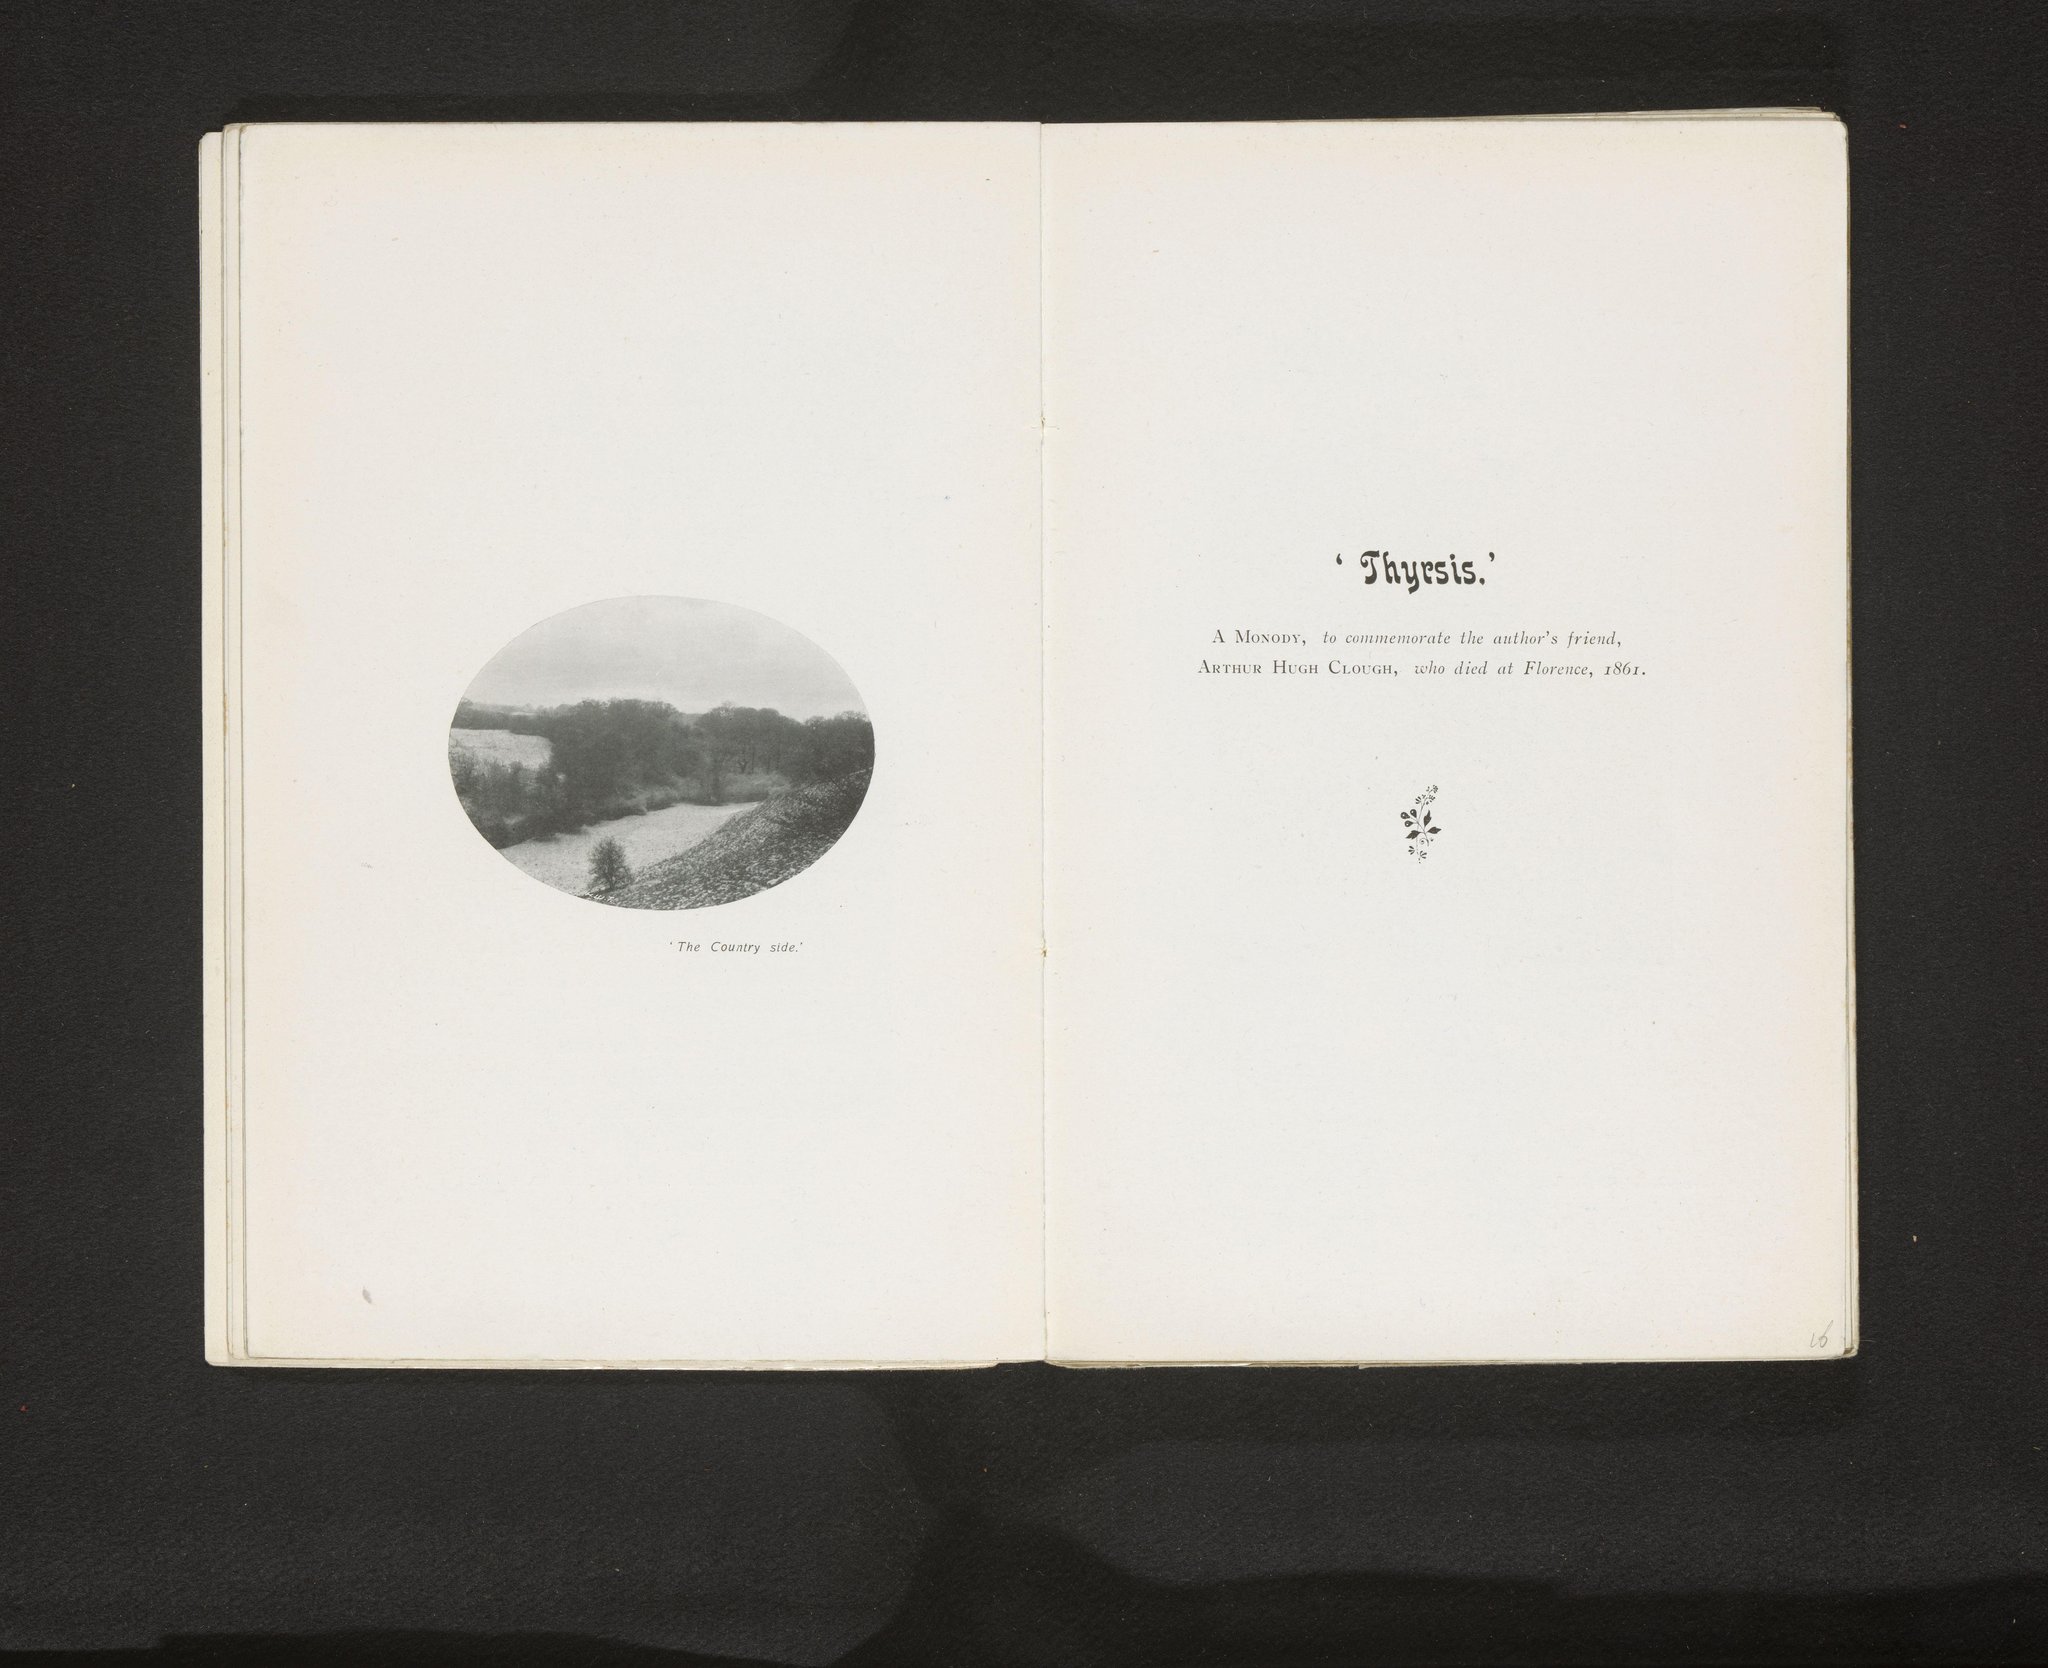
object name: photomechanical print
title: Gezicht op een boslandschap met een rivier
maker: henry w. taunt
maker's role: fotograaf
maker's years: 1842-1922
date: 1907-1912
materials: paper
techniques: autotype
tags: river, forest, wood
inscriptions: inscription: ‘'The County side.'’